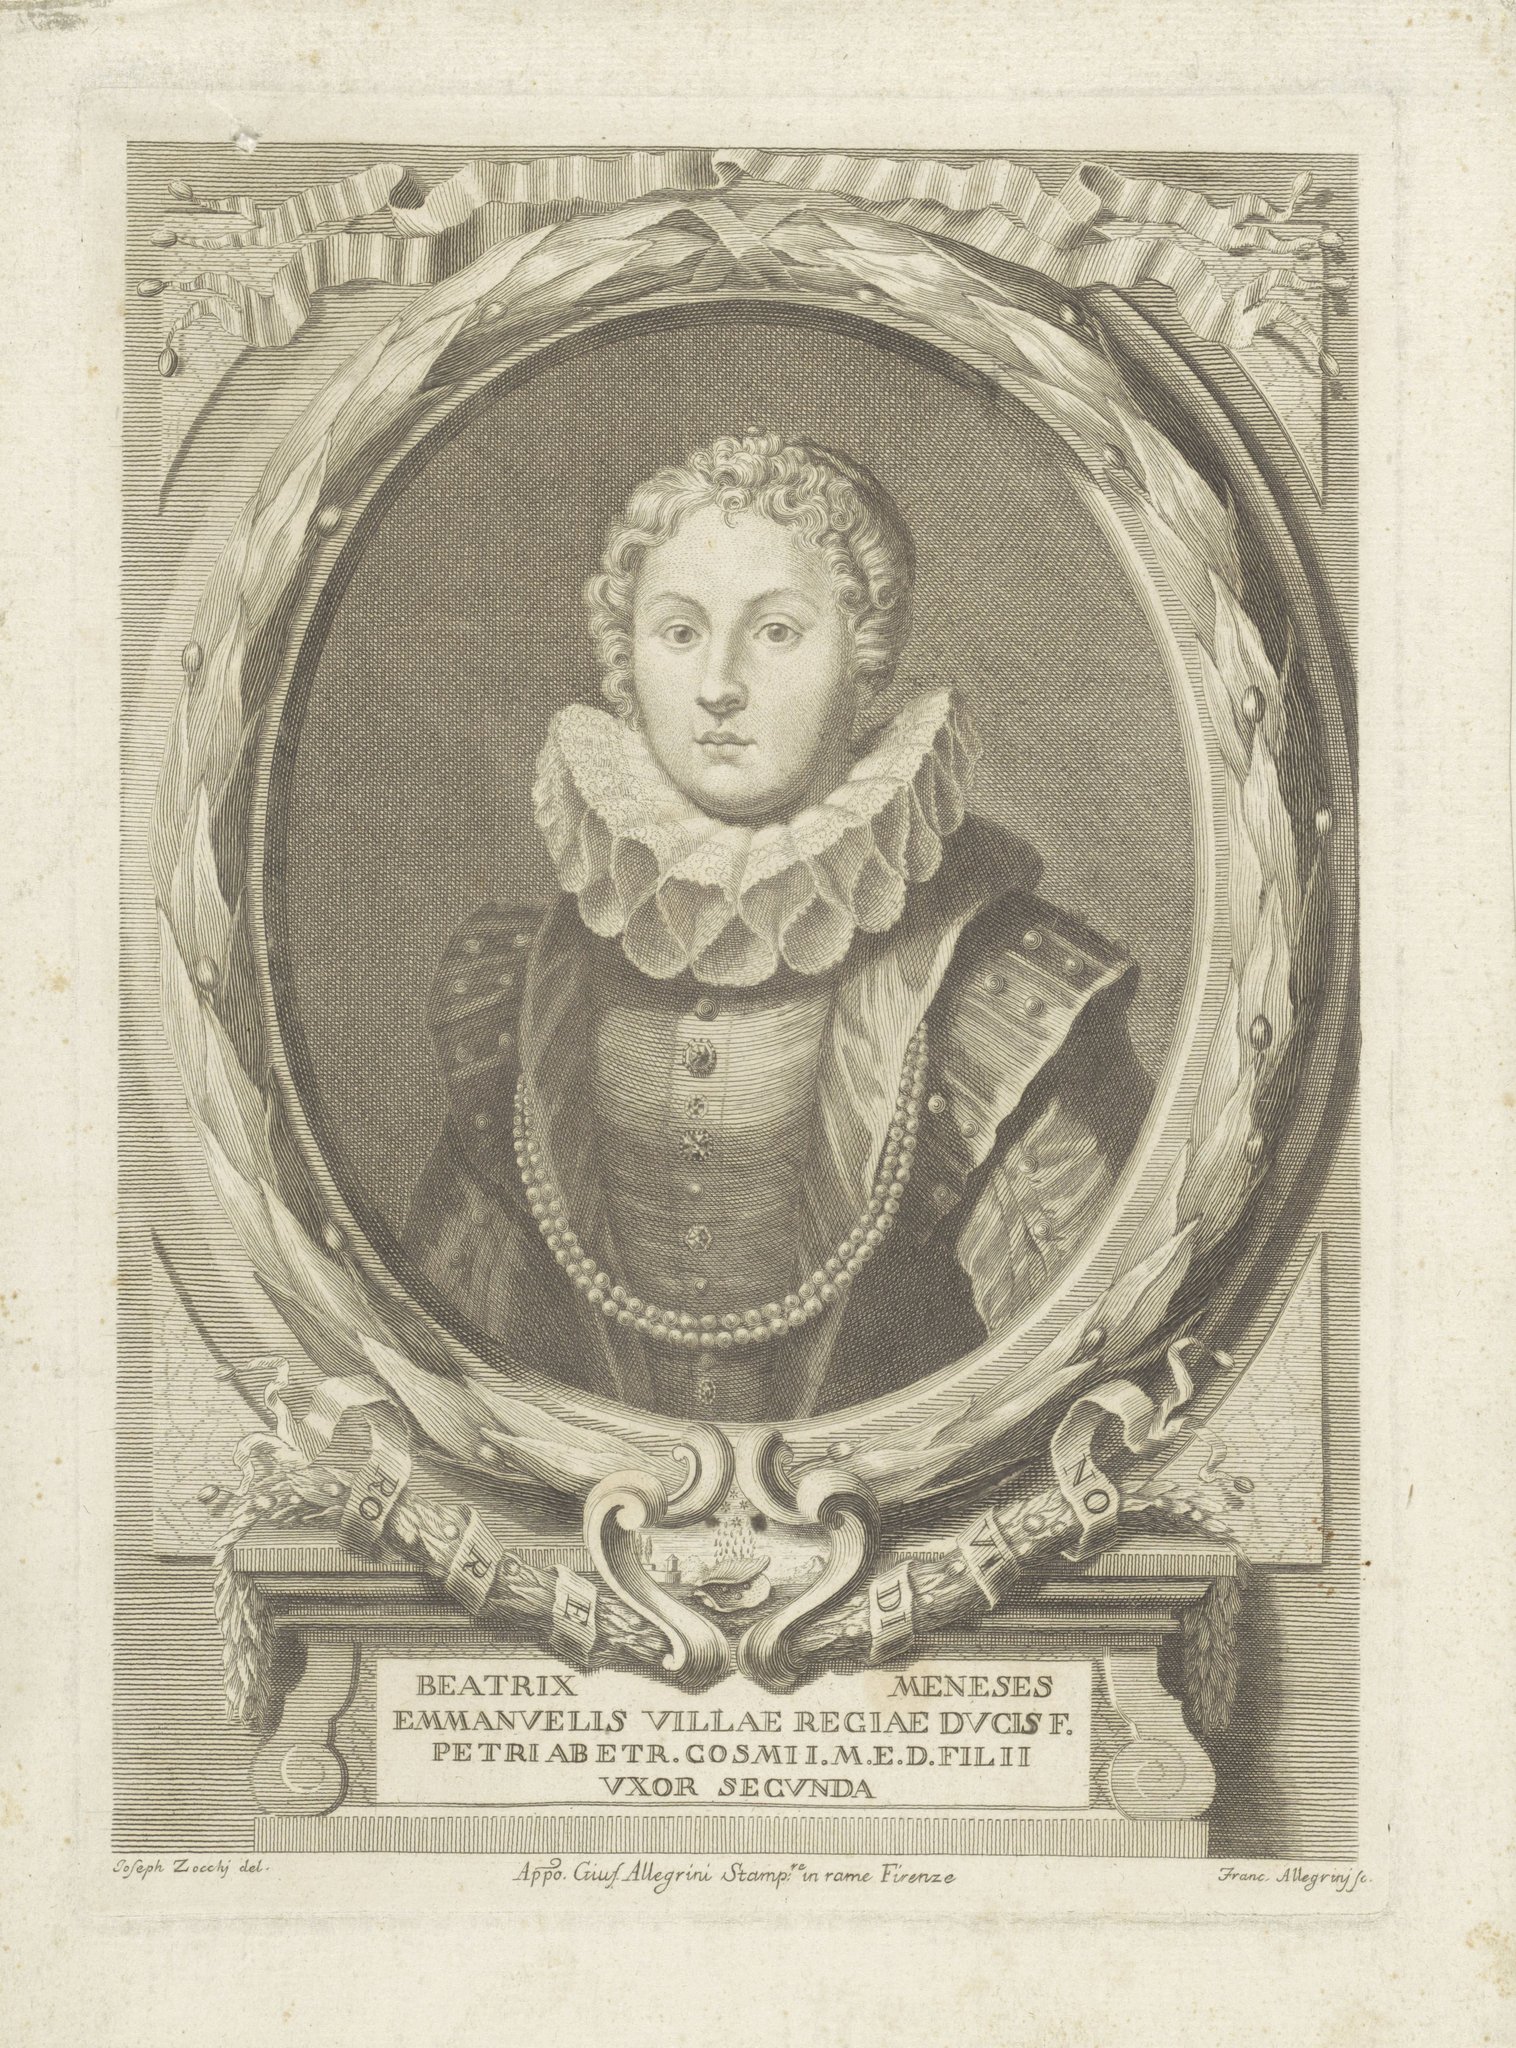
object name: print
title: Portret van Beatrix Meneses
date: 1739-1773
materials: paper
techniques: engraving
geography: italy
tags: historical persons - bb - woman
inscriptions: collector's mark: Lugt 2228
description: Portret van Beatrix Meneses in ovale lijst met bladeren en onder een cartouche met oester. Onder het portret een kader met haar naam.